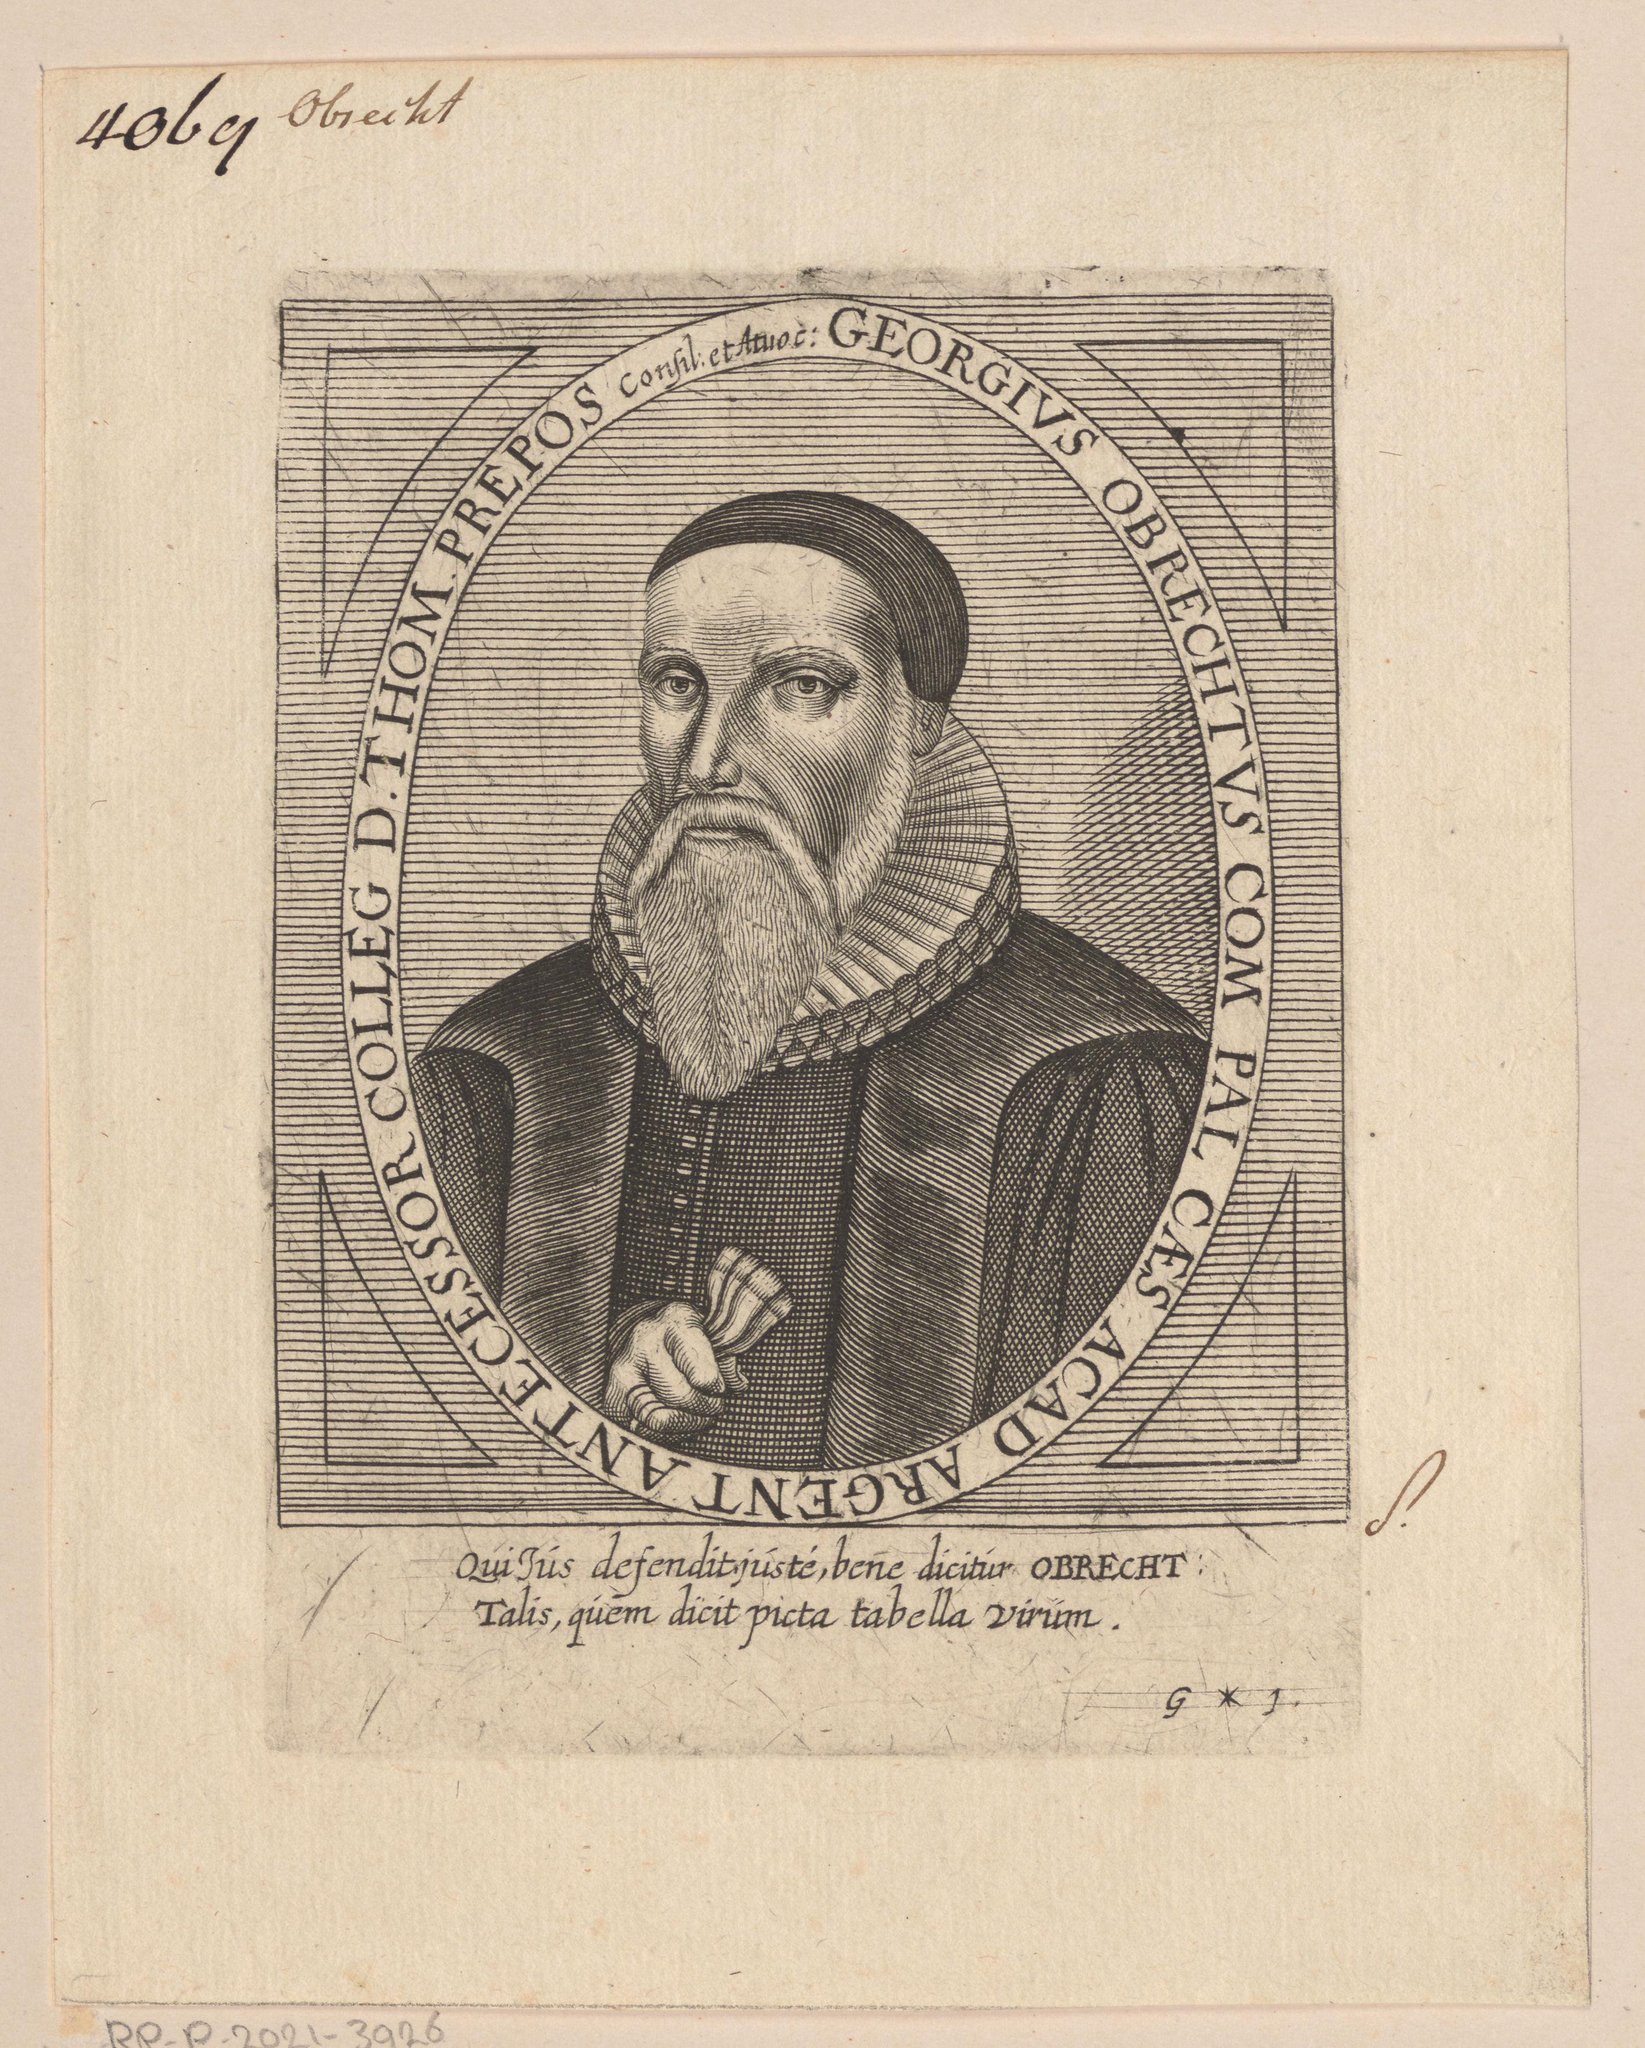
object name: print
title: Portret van Georg von Obrecht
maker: Anonymous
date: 1650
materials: paper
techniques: engraving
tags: gloves, mittens, etc., historical persons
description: Prent mogelijk uit: Boissard, Jean Jacques. Bibliotheca chalcographica (...) VII pars. Frankfurt am Main: Johannes Ammon, 1650, dl. 9.